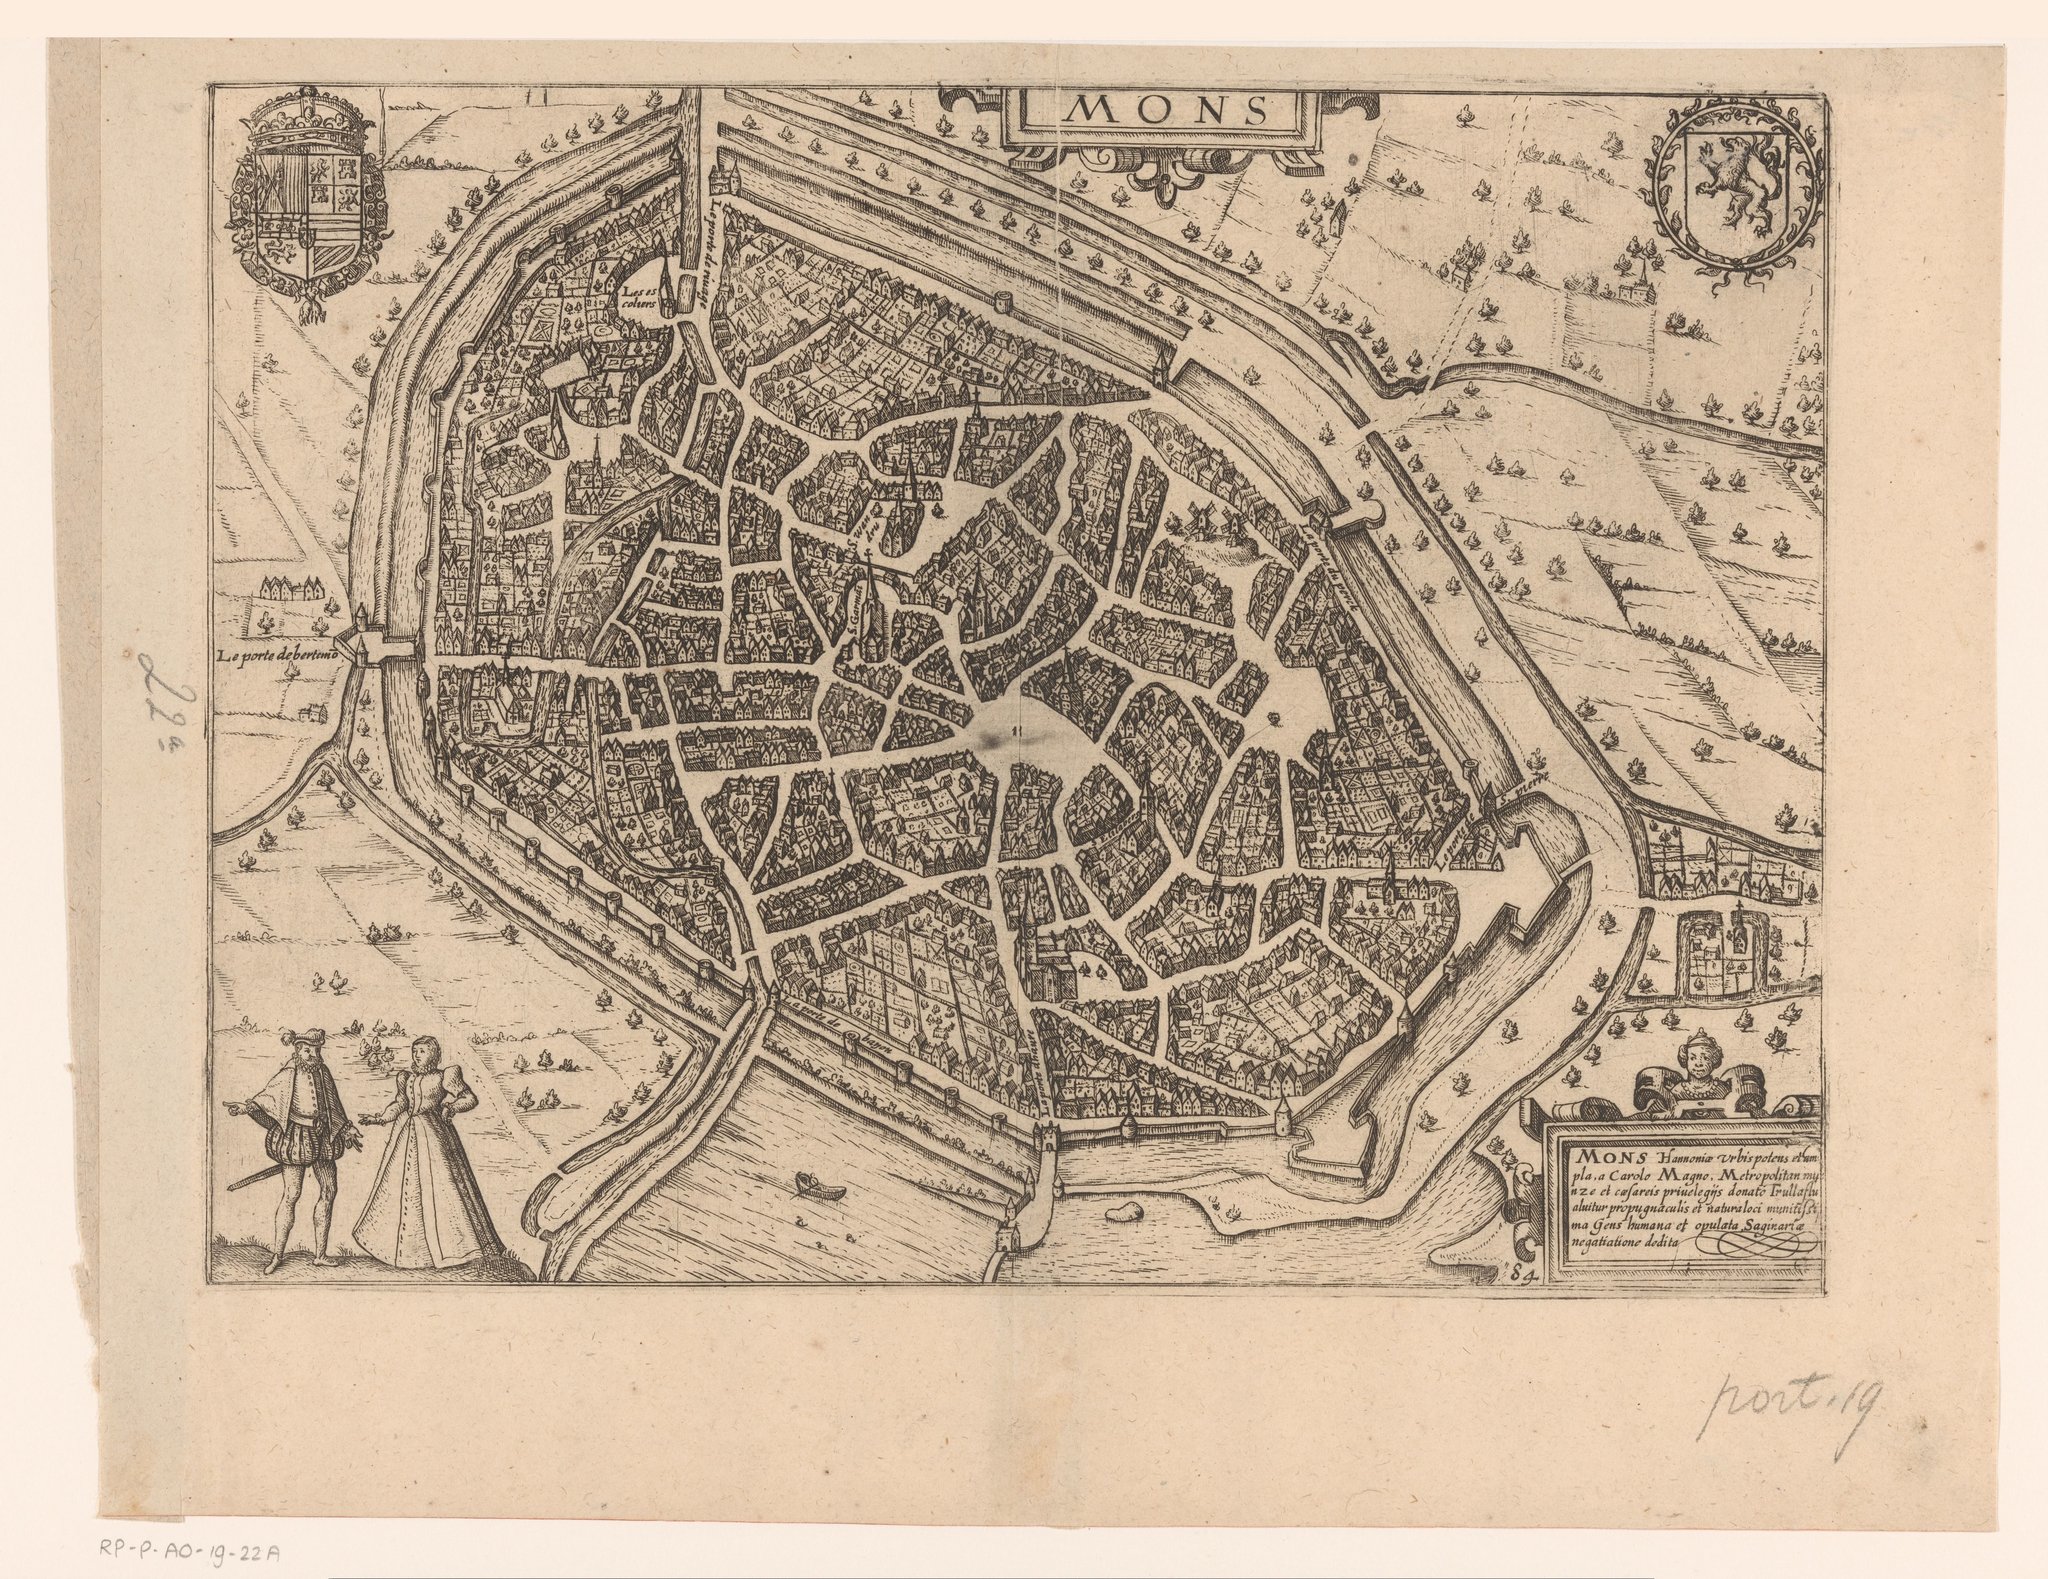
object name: area plan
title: Mons / Mons Hannoniae urbis potens et ampla, a Carolo Magno (...)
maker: Anonymous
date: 1612-1648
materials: paper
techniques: engraving, etching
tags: coat of arms (as symbol of the state, etc.) (+ city; municipal), maps of cities, armorial bearing, heraldry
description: Deze staat van prent voor het eerst ook gebruikt in: Guicciardini, Lodovico. Beschryvinghe van alle de Neder-landen, anderssins ghenoemt Neder-Duytslandt (…). Amsterdam: Willem Janszoon Blaeu, 1612. Hierna is deze prent tot 1648 nog gebruikt in latere uitgaven van deze publicatie, uitgegeven door Blaeu en daarna door Janssonius. Uit welke uitgave het huidige exemplaar precies komt is niet na te gaan.